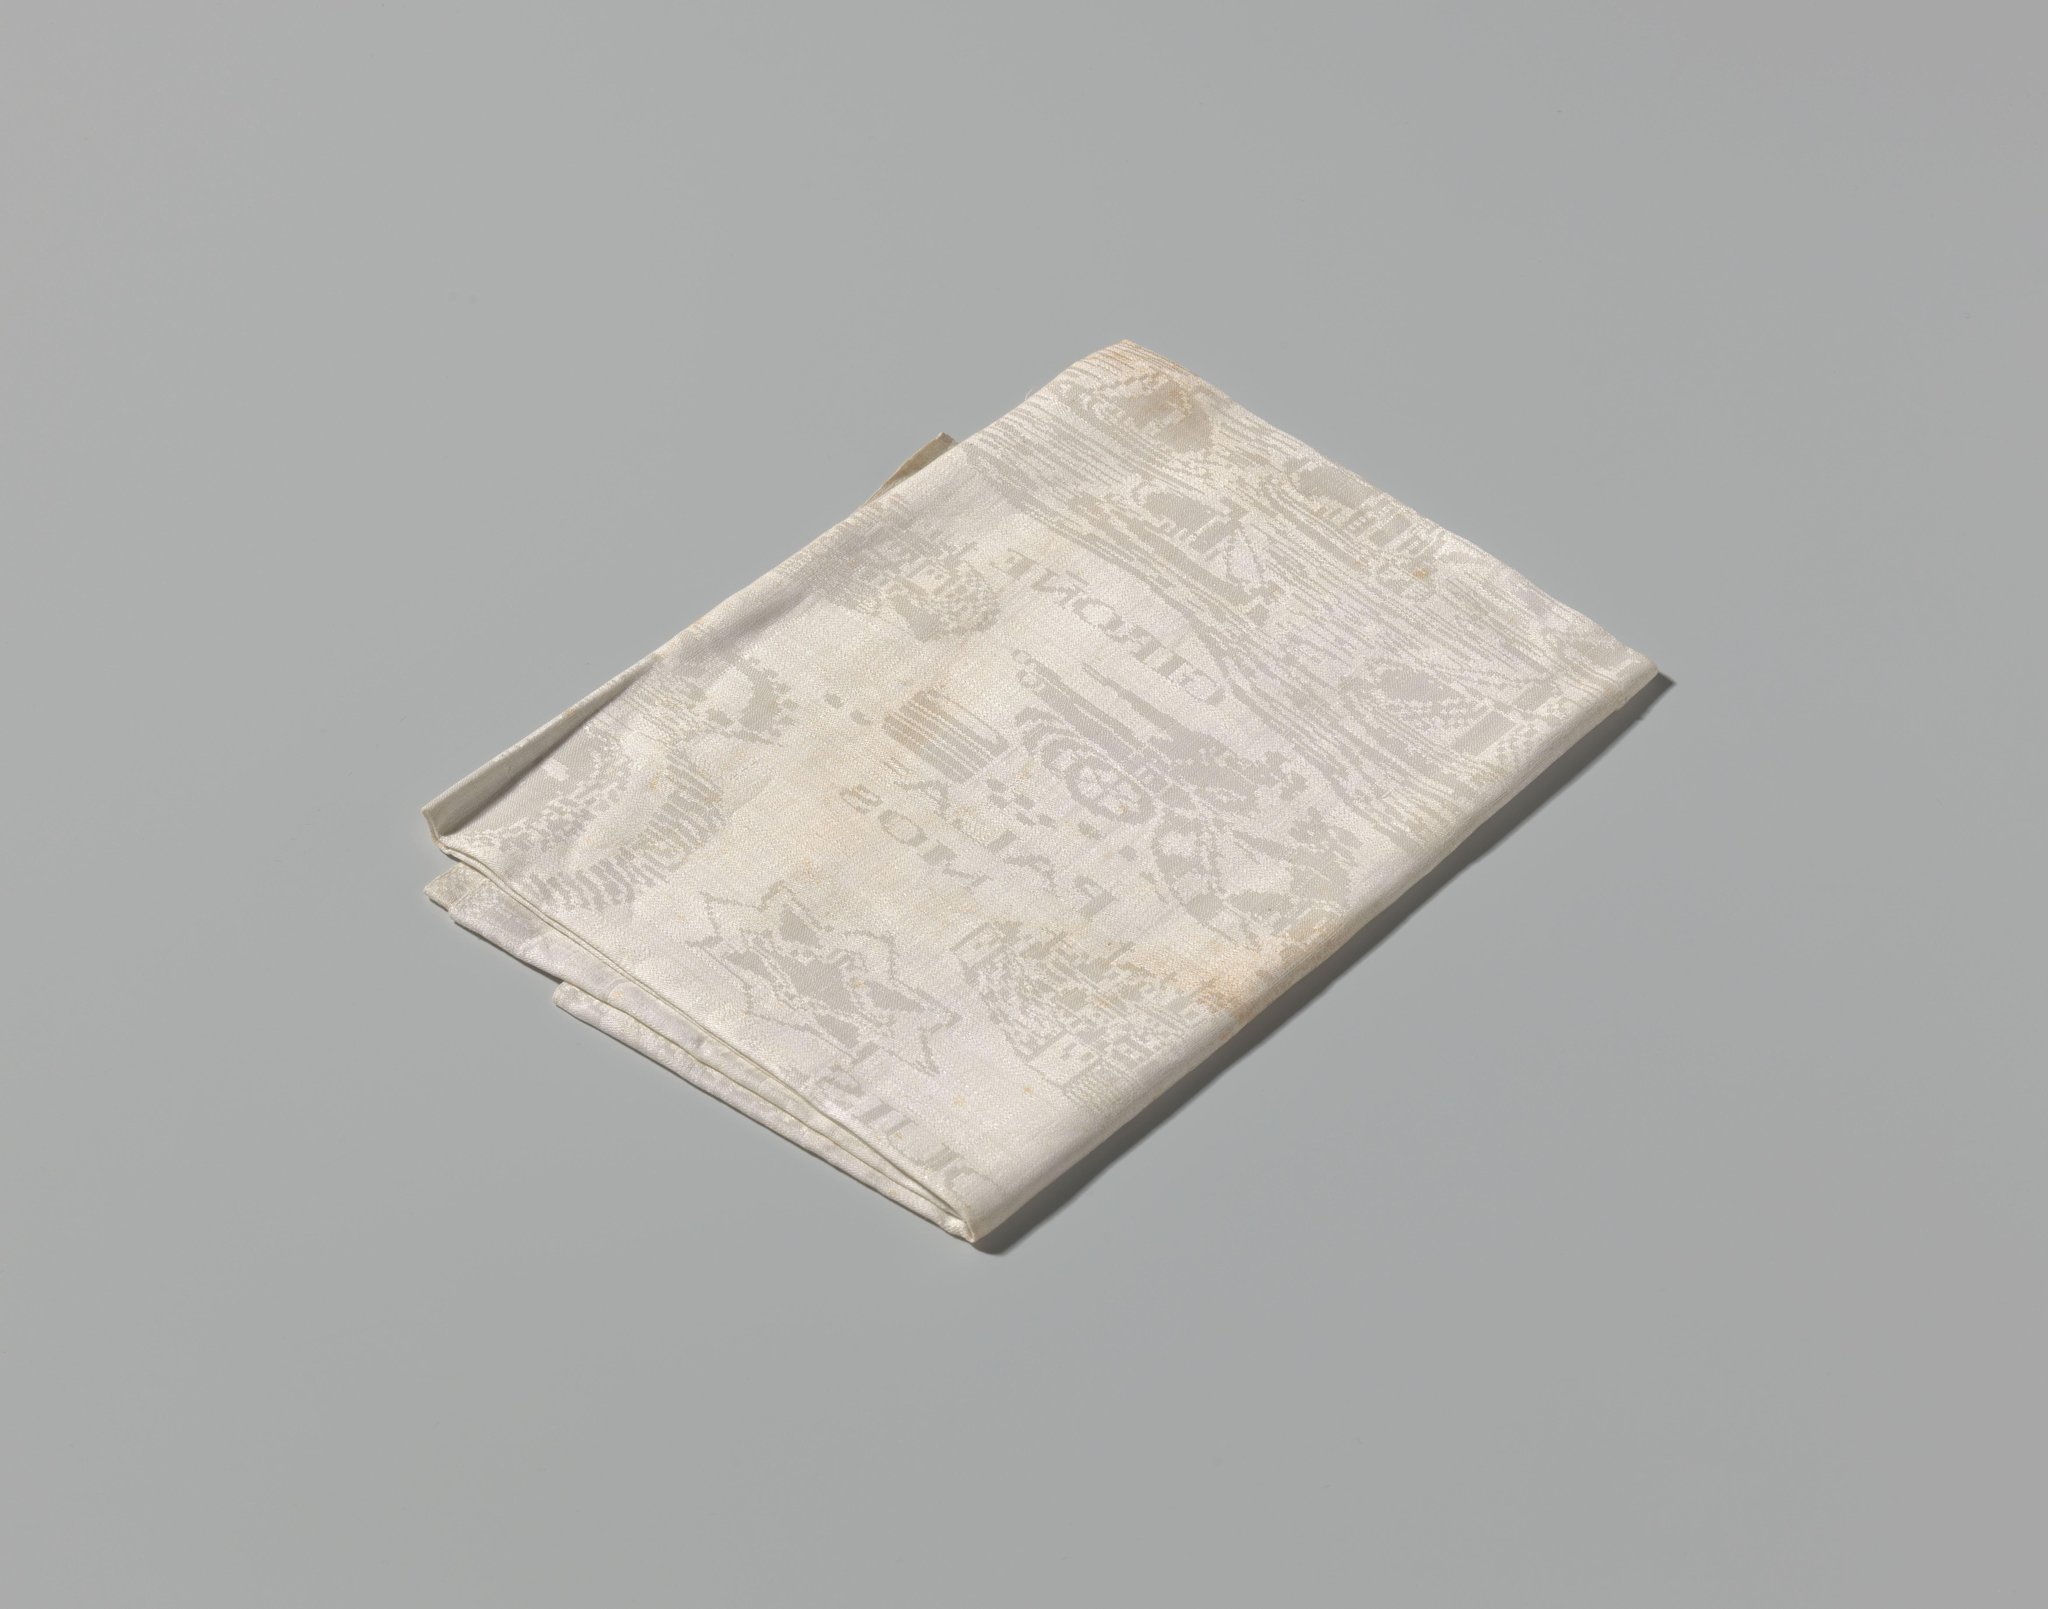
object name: napkin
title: Servet van wit linnendamast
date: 1694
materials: linen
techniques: damask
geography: southern netherlands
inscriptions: mark: ‘BSDI’, mark: ‘12’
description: Witlinnen damasten servet met voorstellingen van de Catalaanse veldtocht van Lodewijk XIV, met de inwevingen "ROSE","PALLAMOS", "GIRONE", gemerkt BSDI 12.